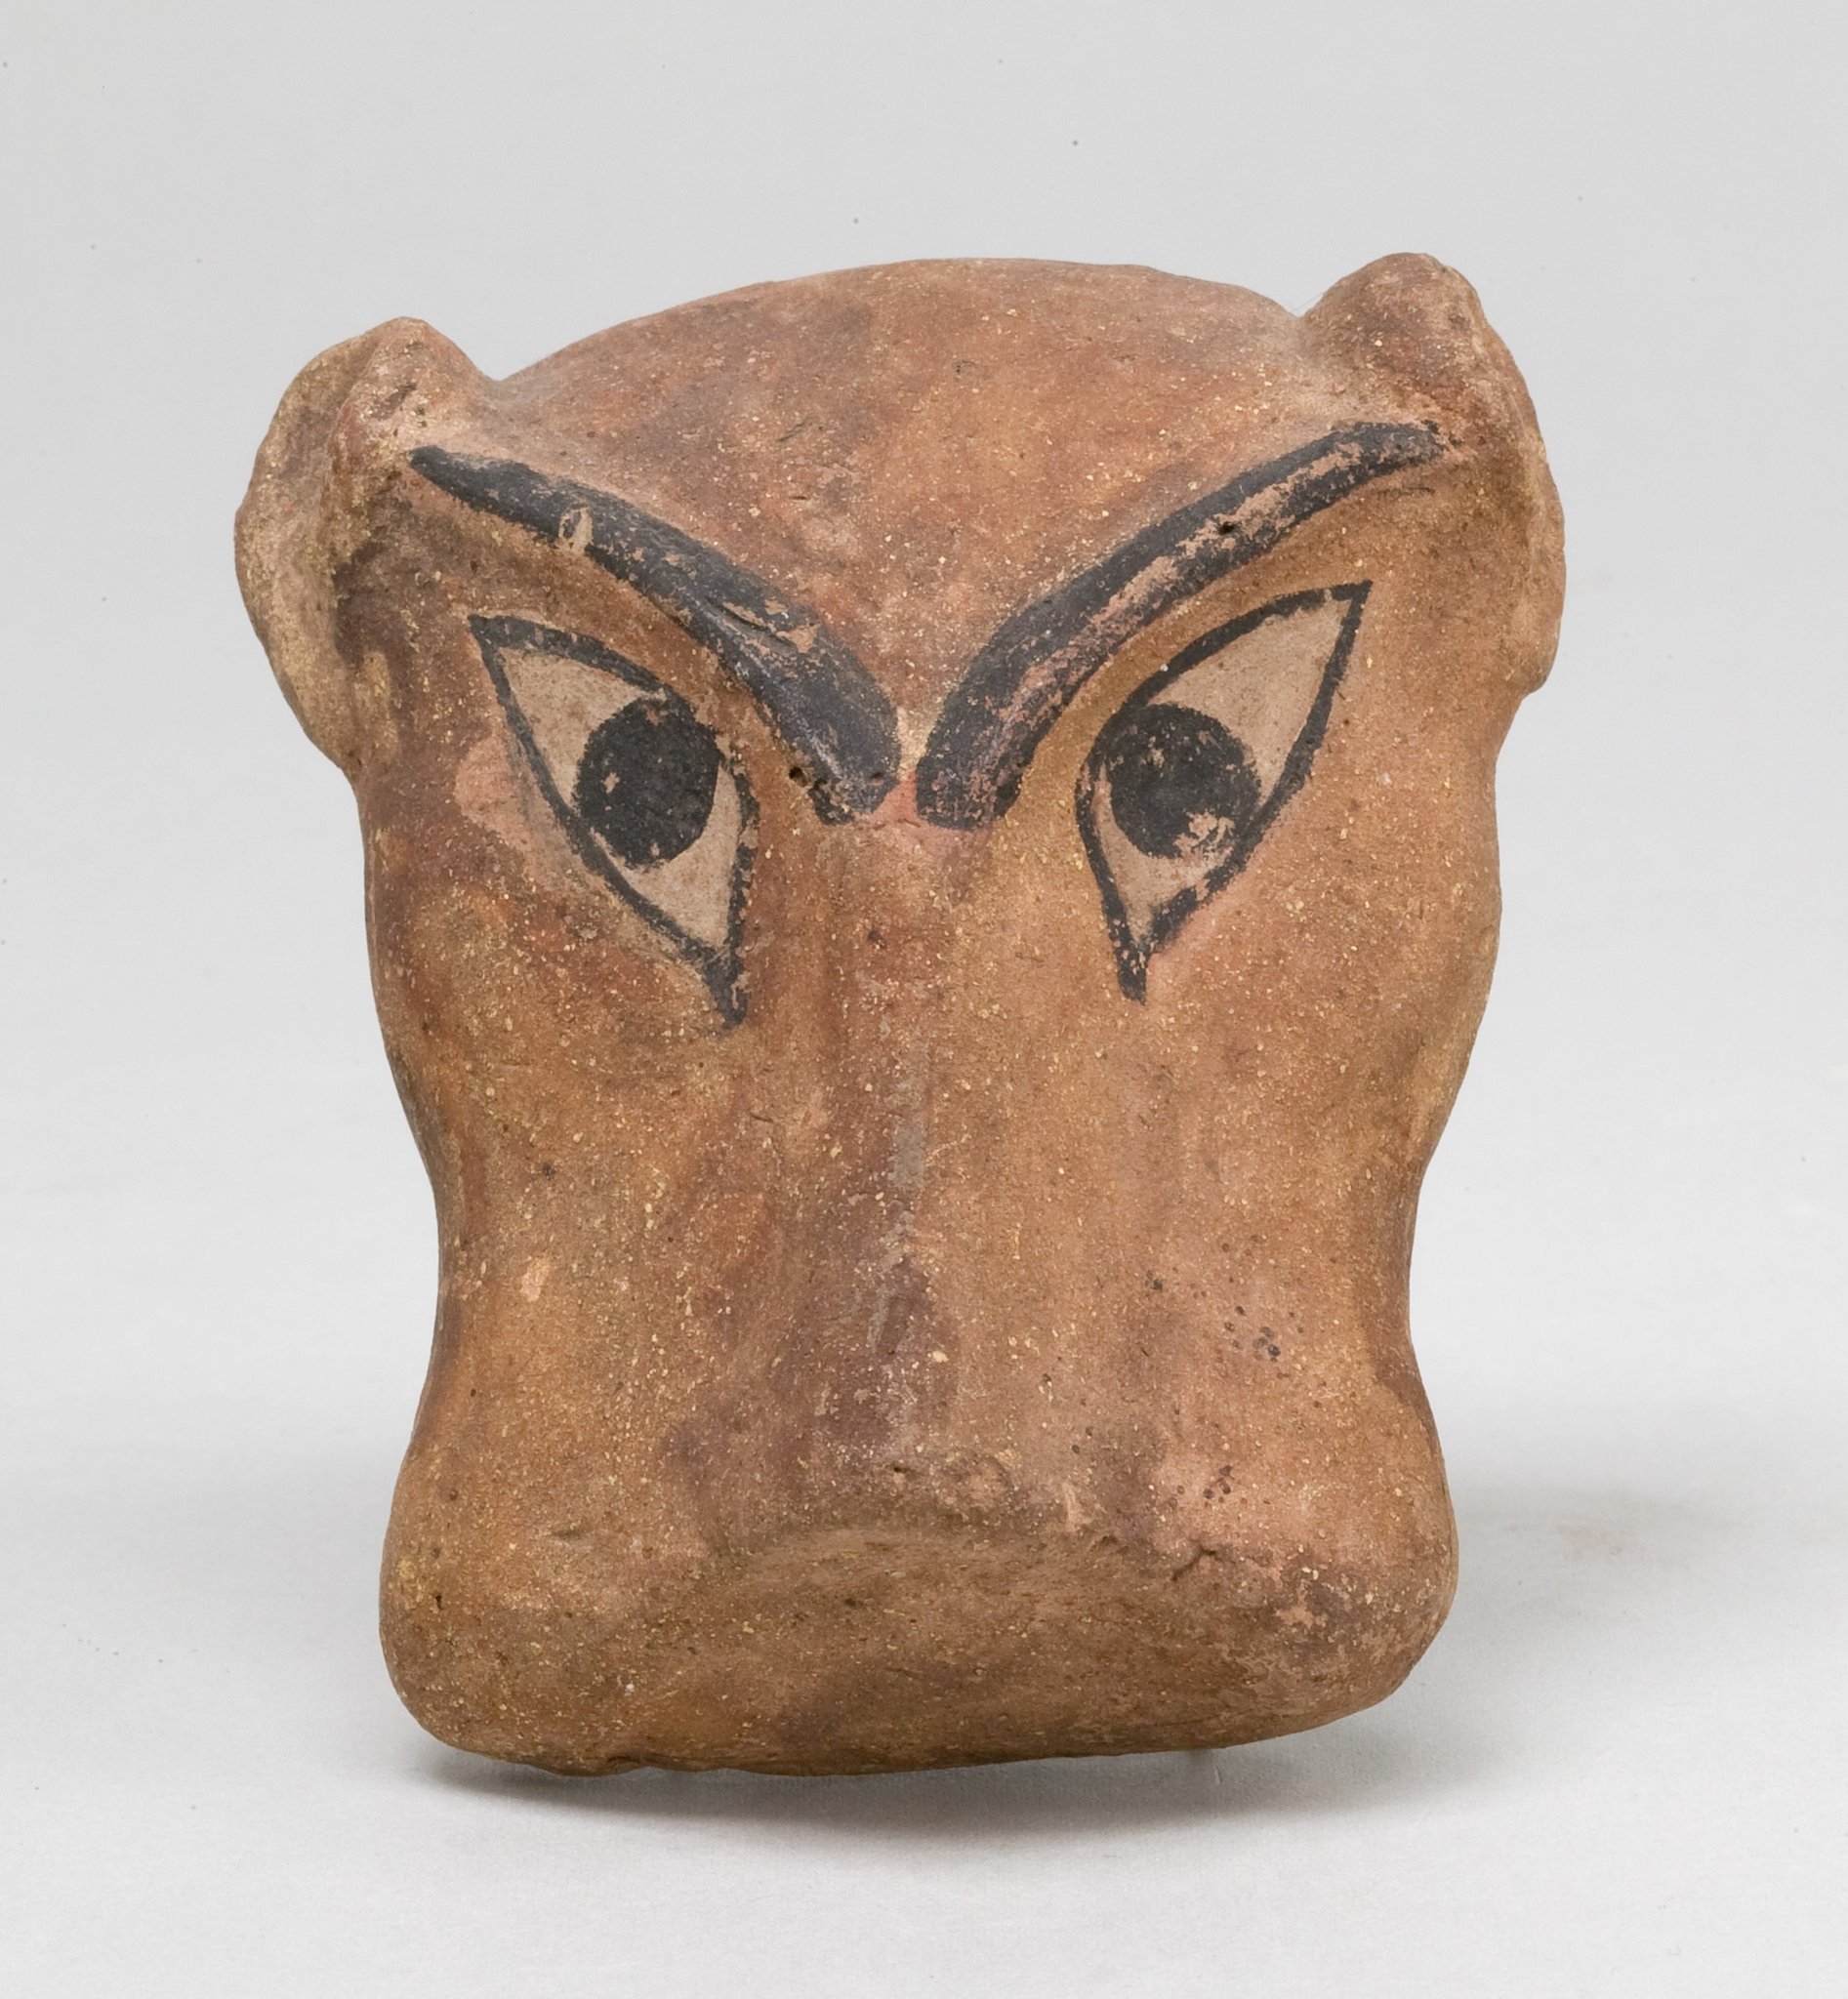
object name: leopard's head from priest's robe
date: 1550-1295 BCE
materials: pottery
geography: egypt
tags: masks